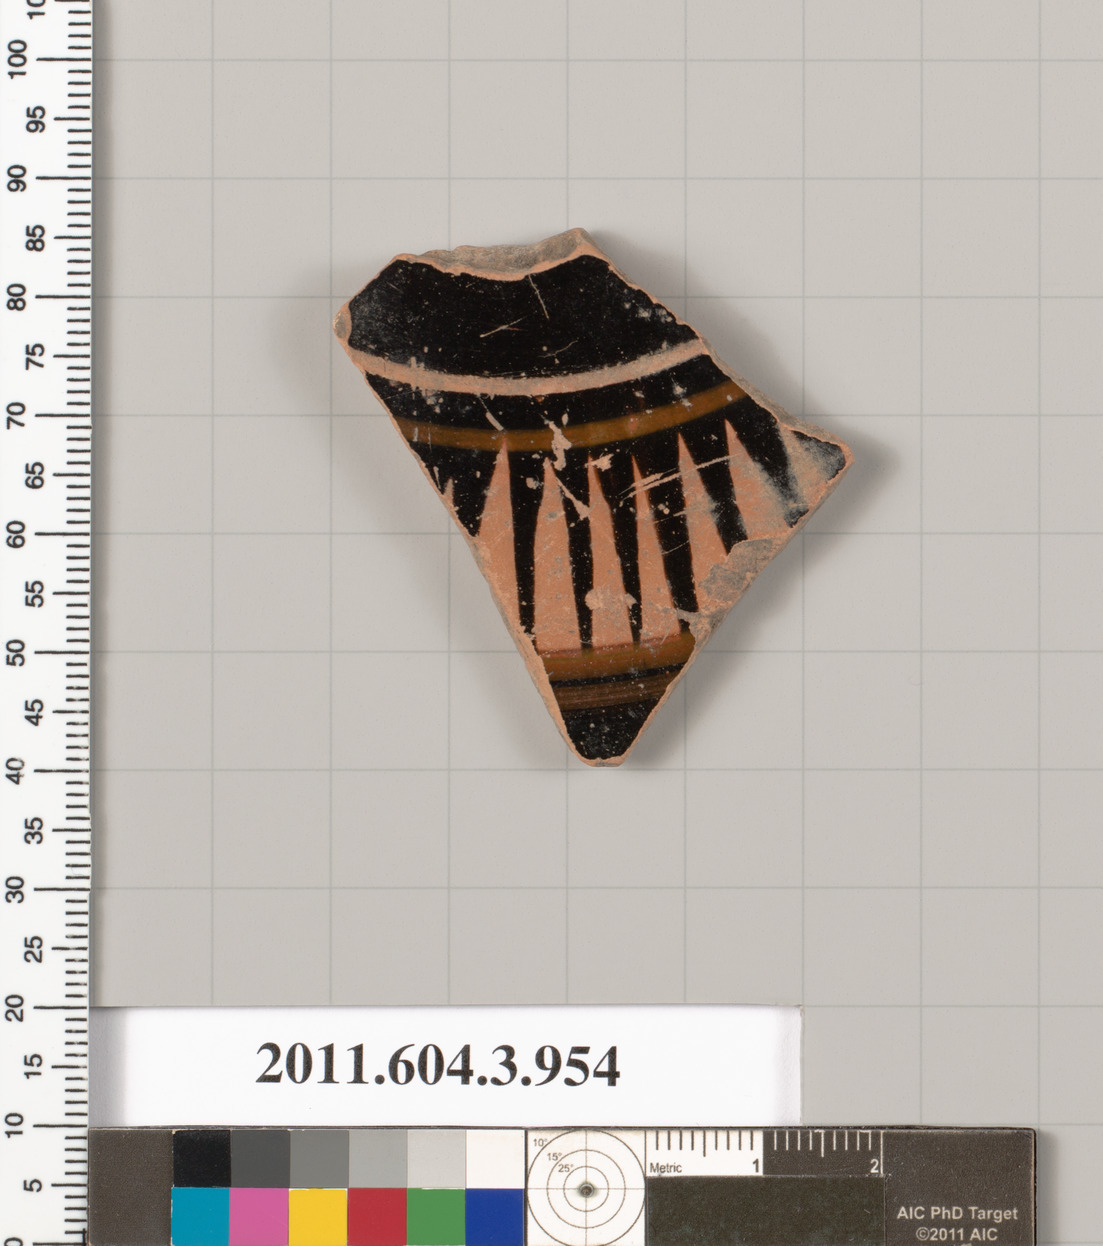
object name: lekanis lid fragment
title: Terracotta fragment of a lekanis lid (covered dish)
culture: greek, attic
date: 600-501 BCE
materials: terracotta